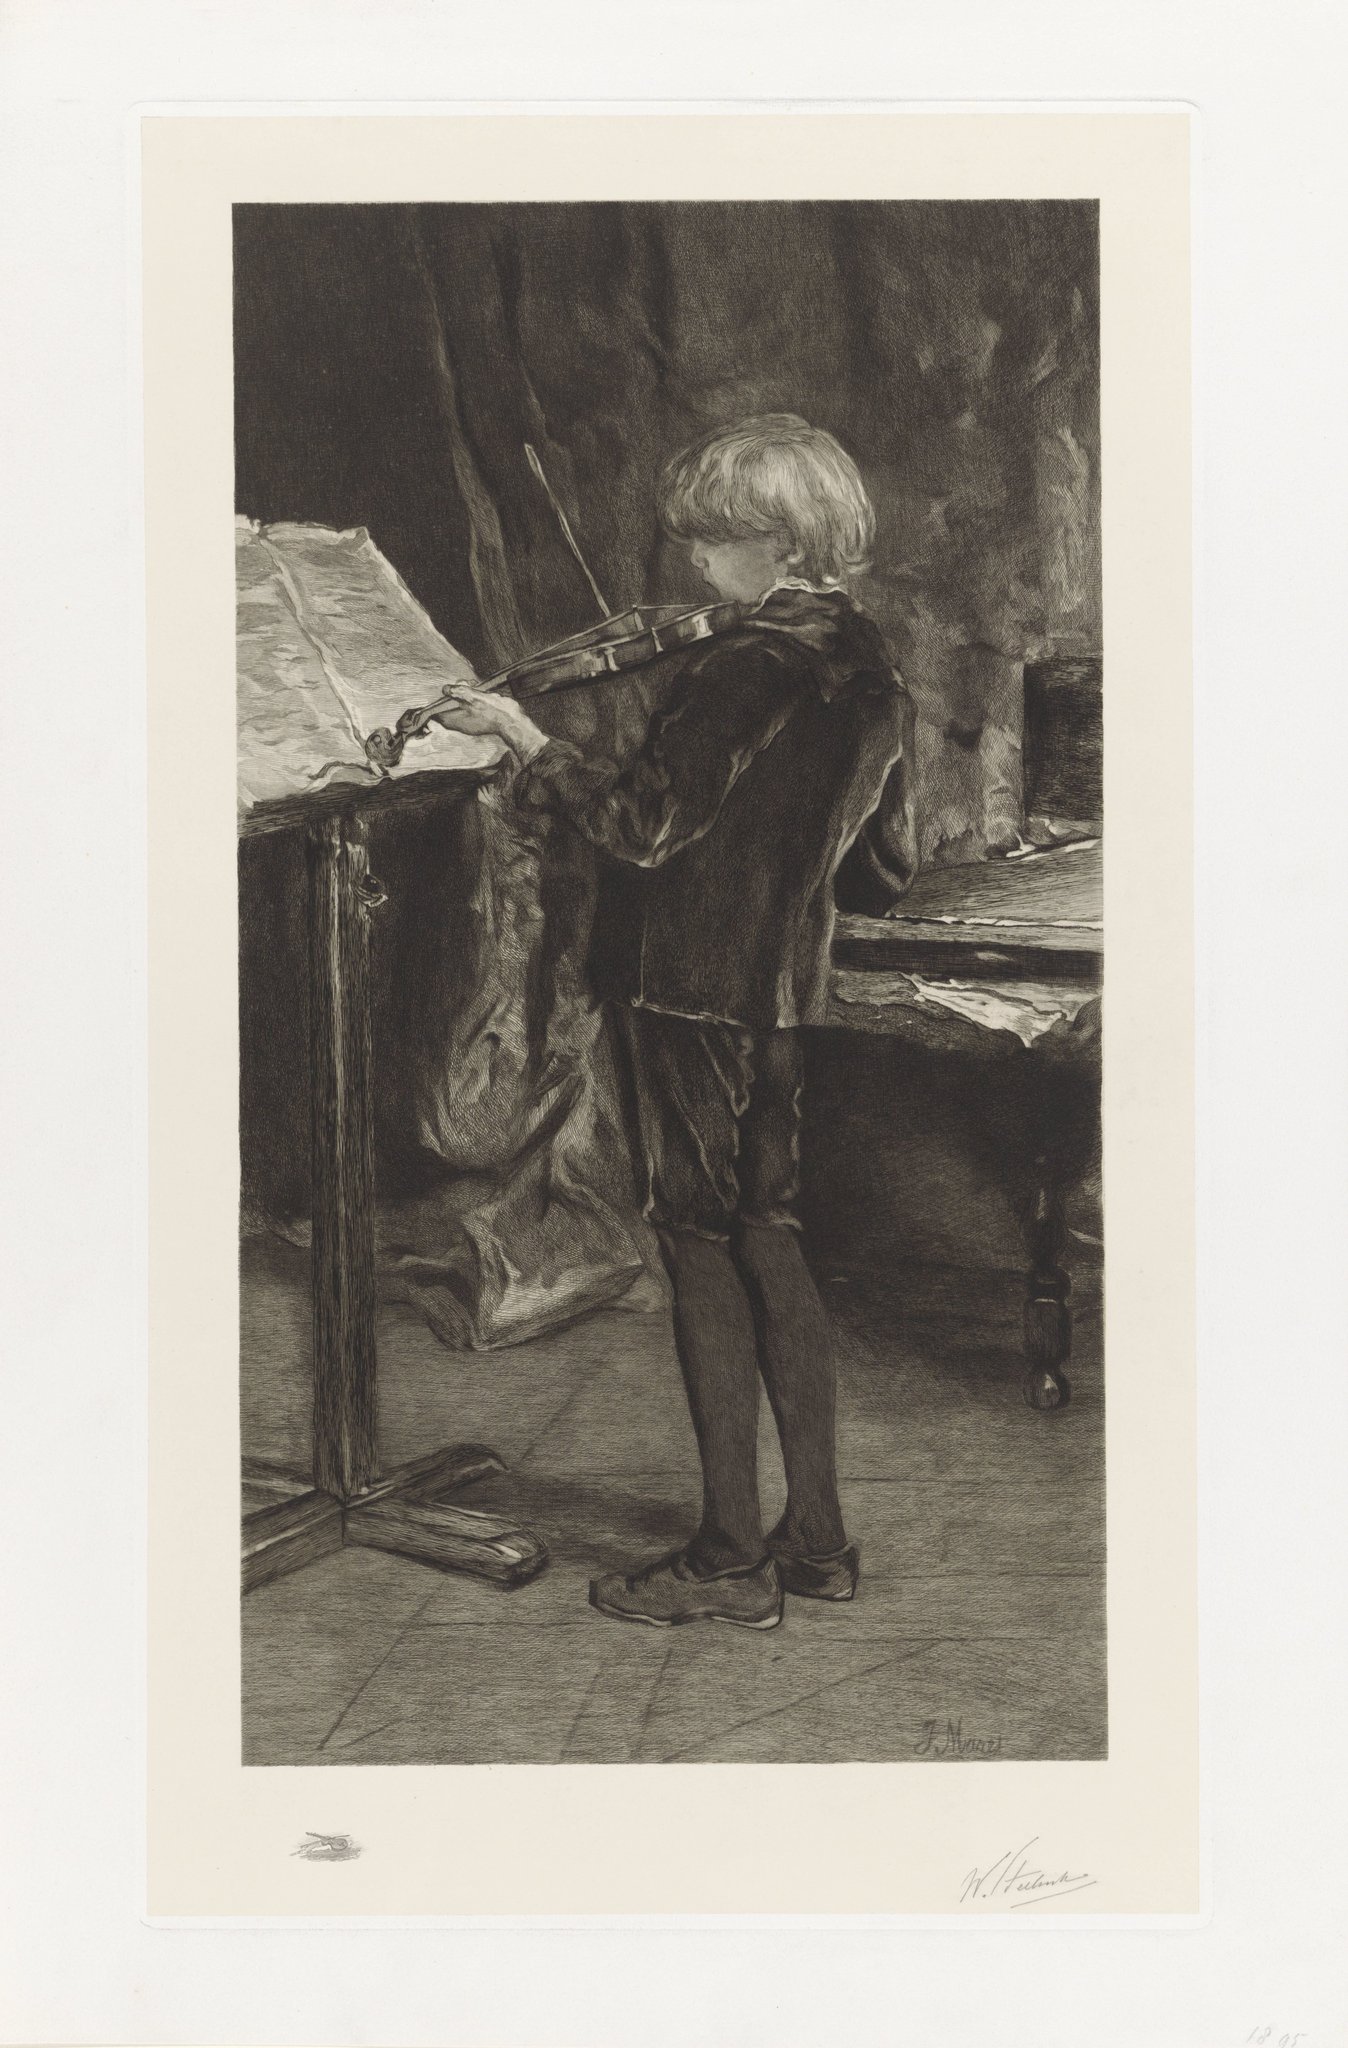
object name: print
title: Jonge vioolspeler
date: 1866-1895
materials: paper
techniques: etching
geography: netherlands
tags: one person playing string instrument (bowed), violin, fiddle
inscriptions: collector's mark: Lugt 2228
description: Een jongen speelt viool staande bij een lessenaar. Linksonder in de marge een viool met strijkstok.